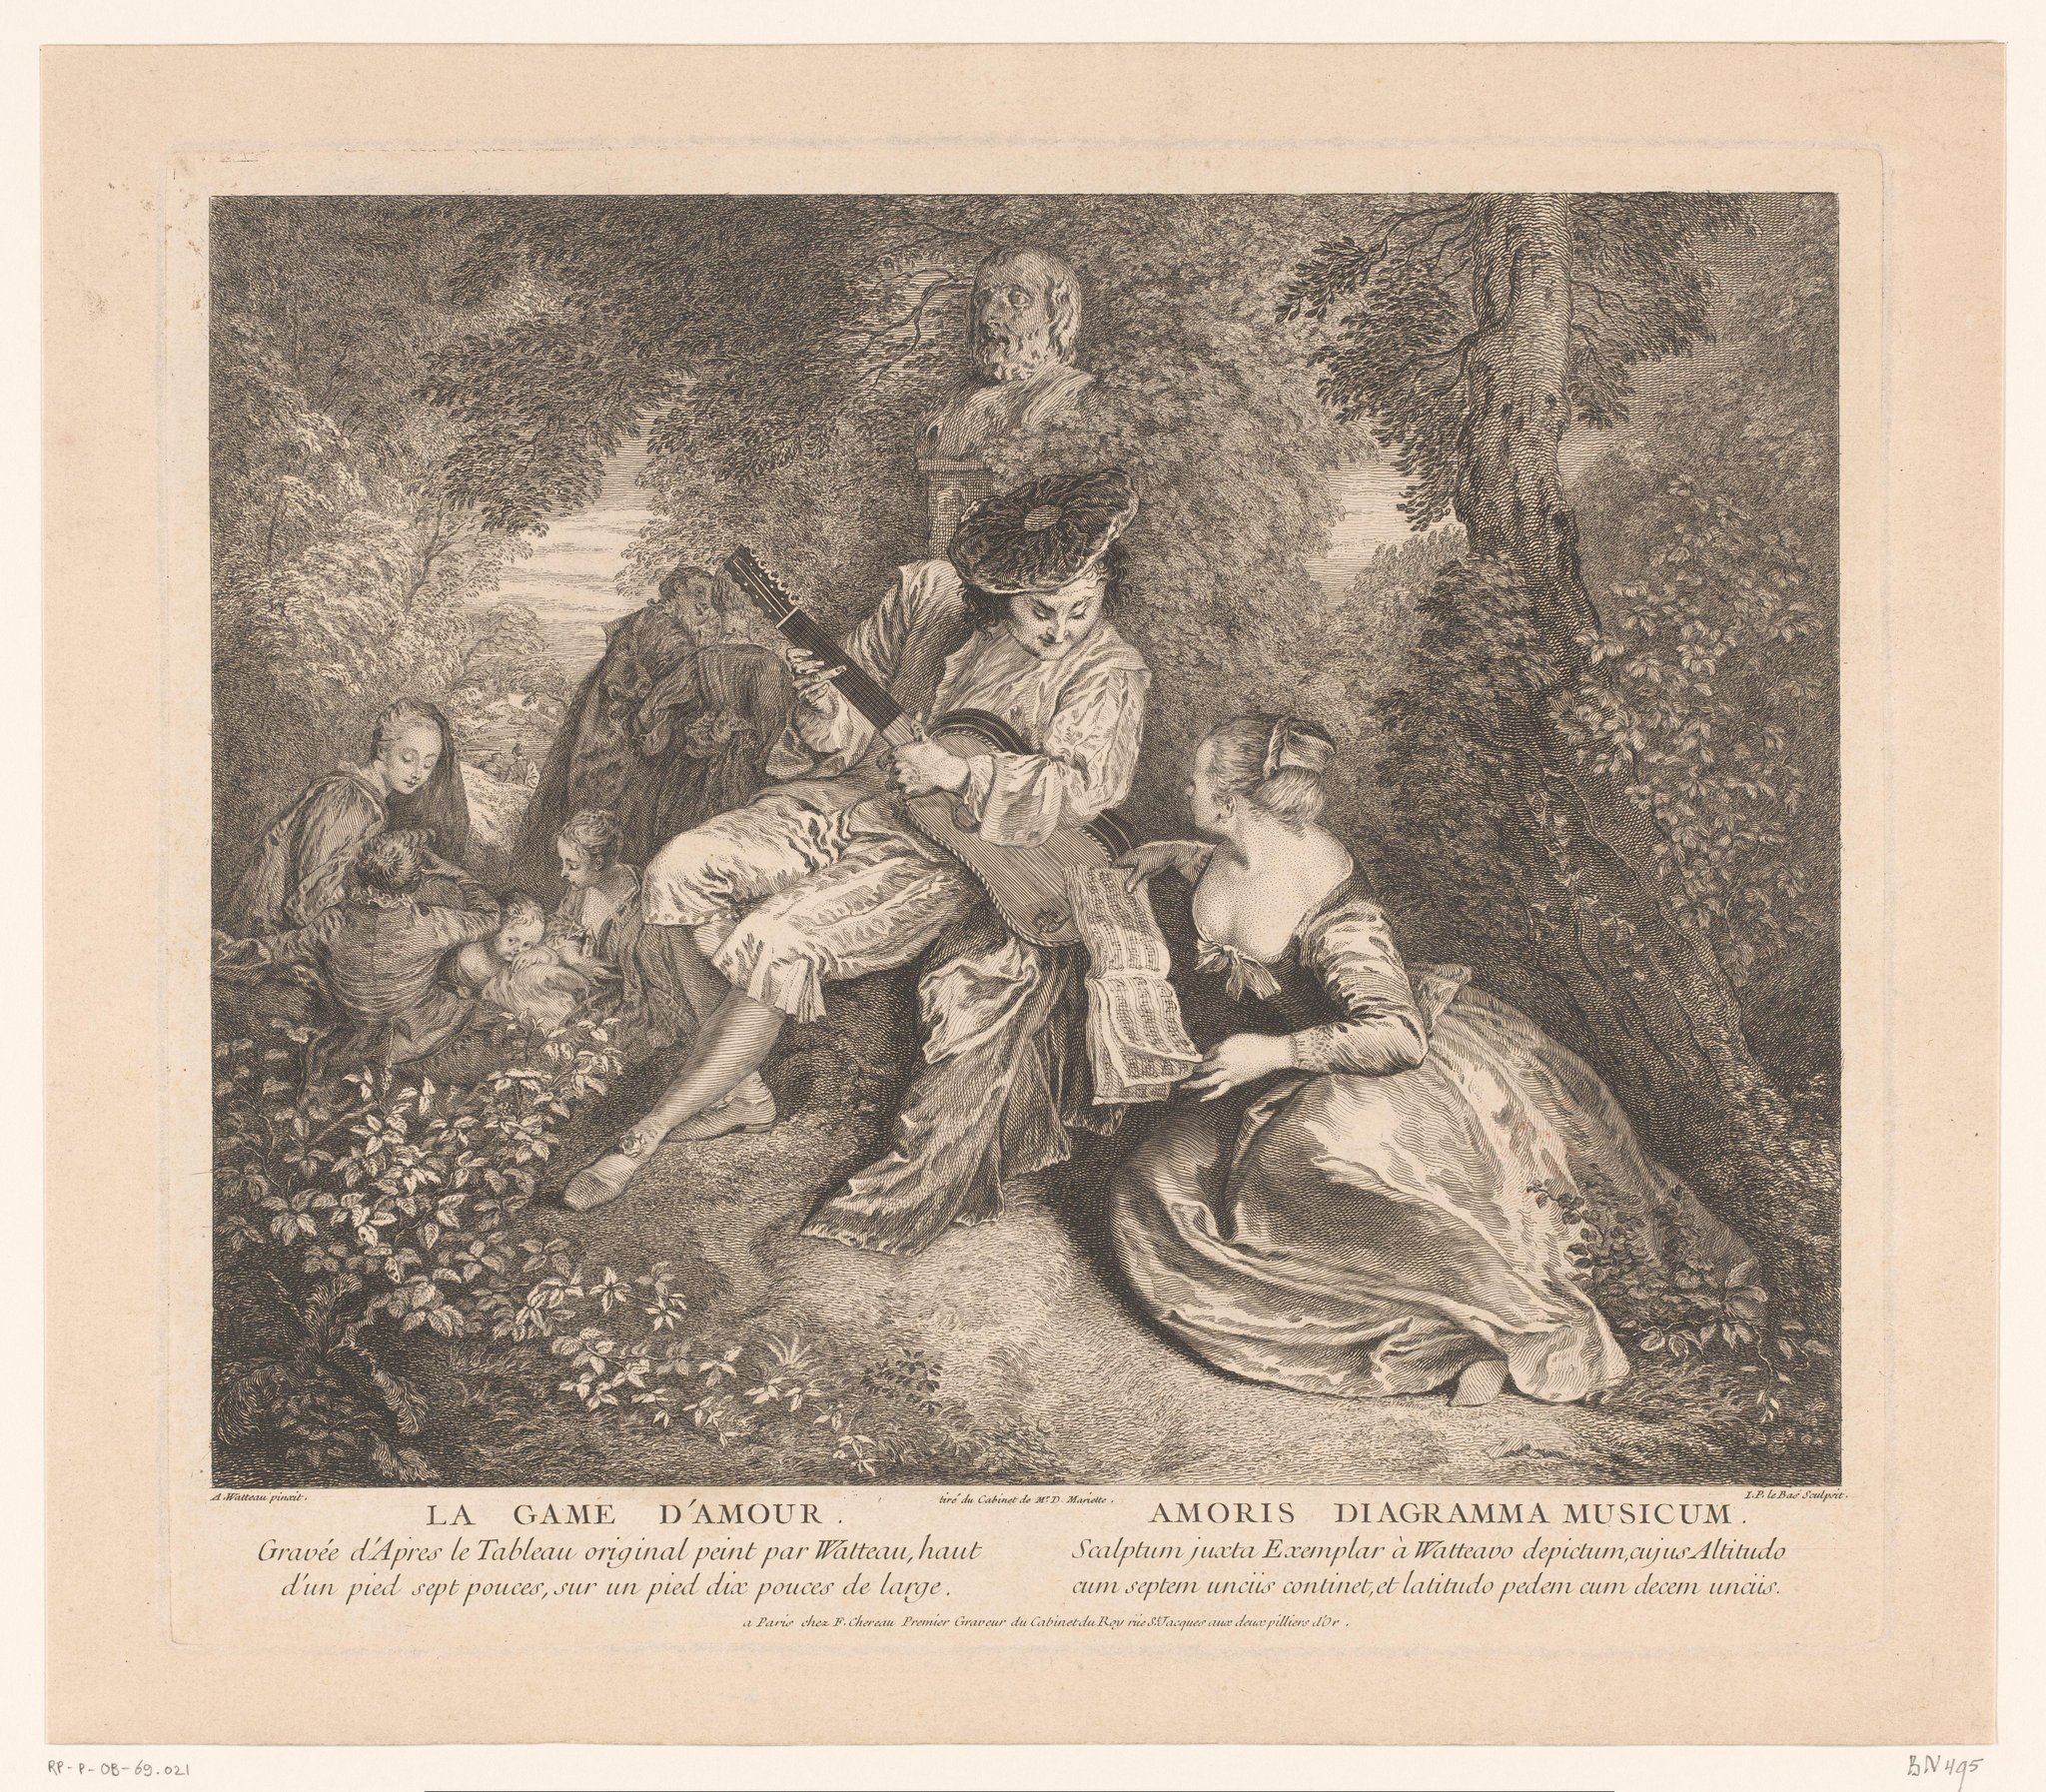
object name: print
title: La game d'Amour - Amoris Diagramma Musicum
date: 1717-1729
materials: paper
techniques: engraving, etching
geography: paris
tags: making music; musician with instrument - cc - out of doors, garden of love, court of love, 'fête galante', courting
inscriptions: collector's mark: Lugt 240